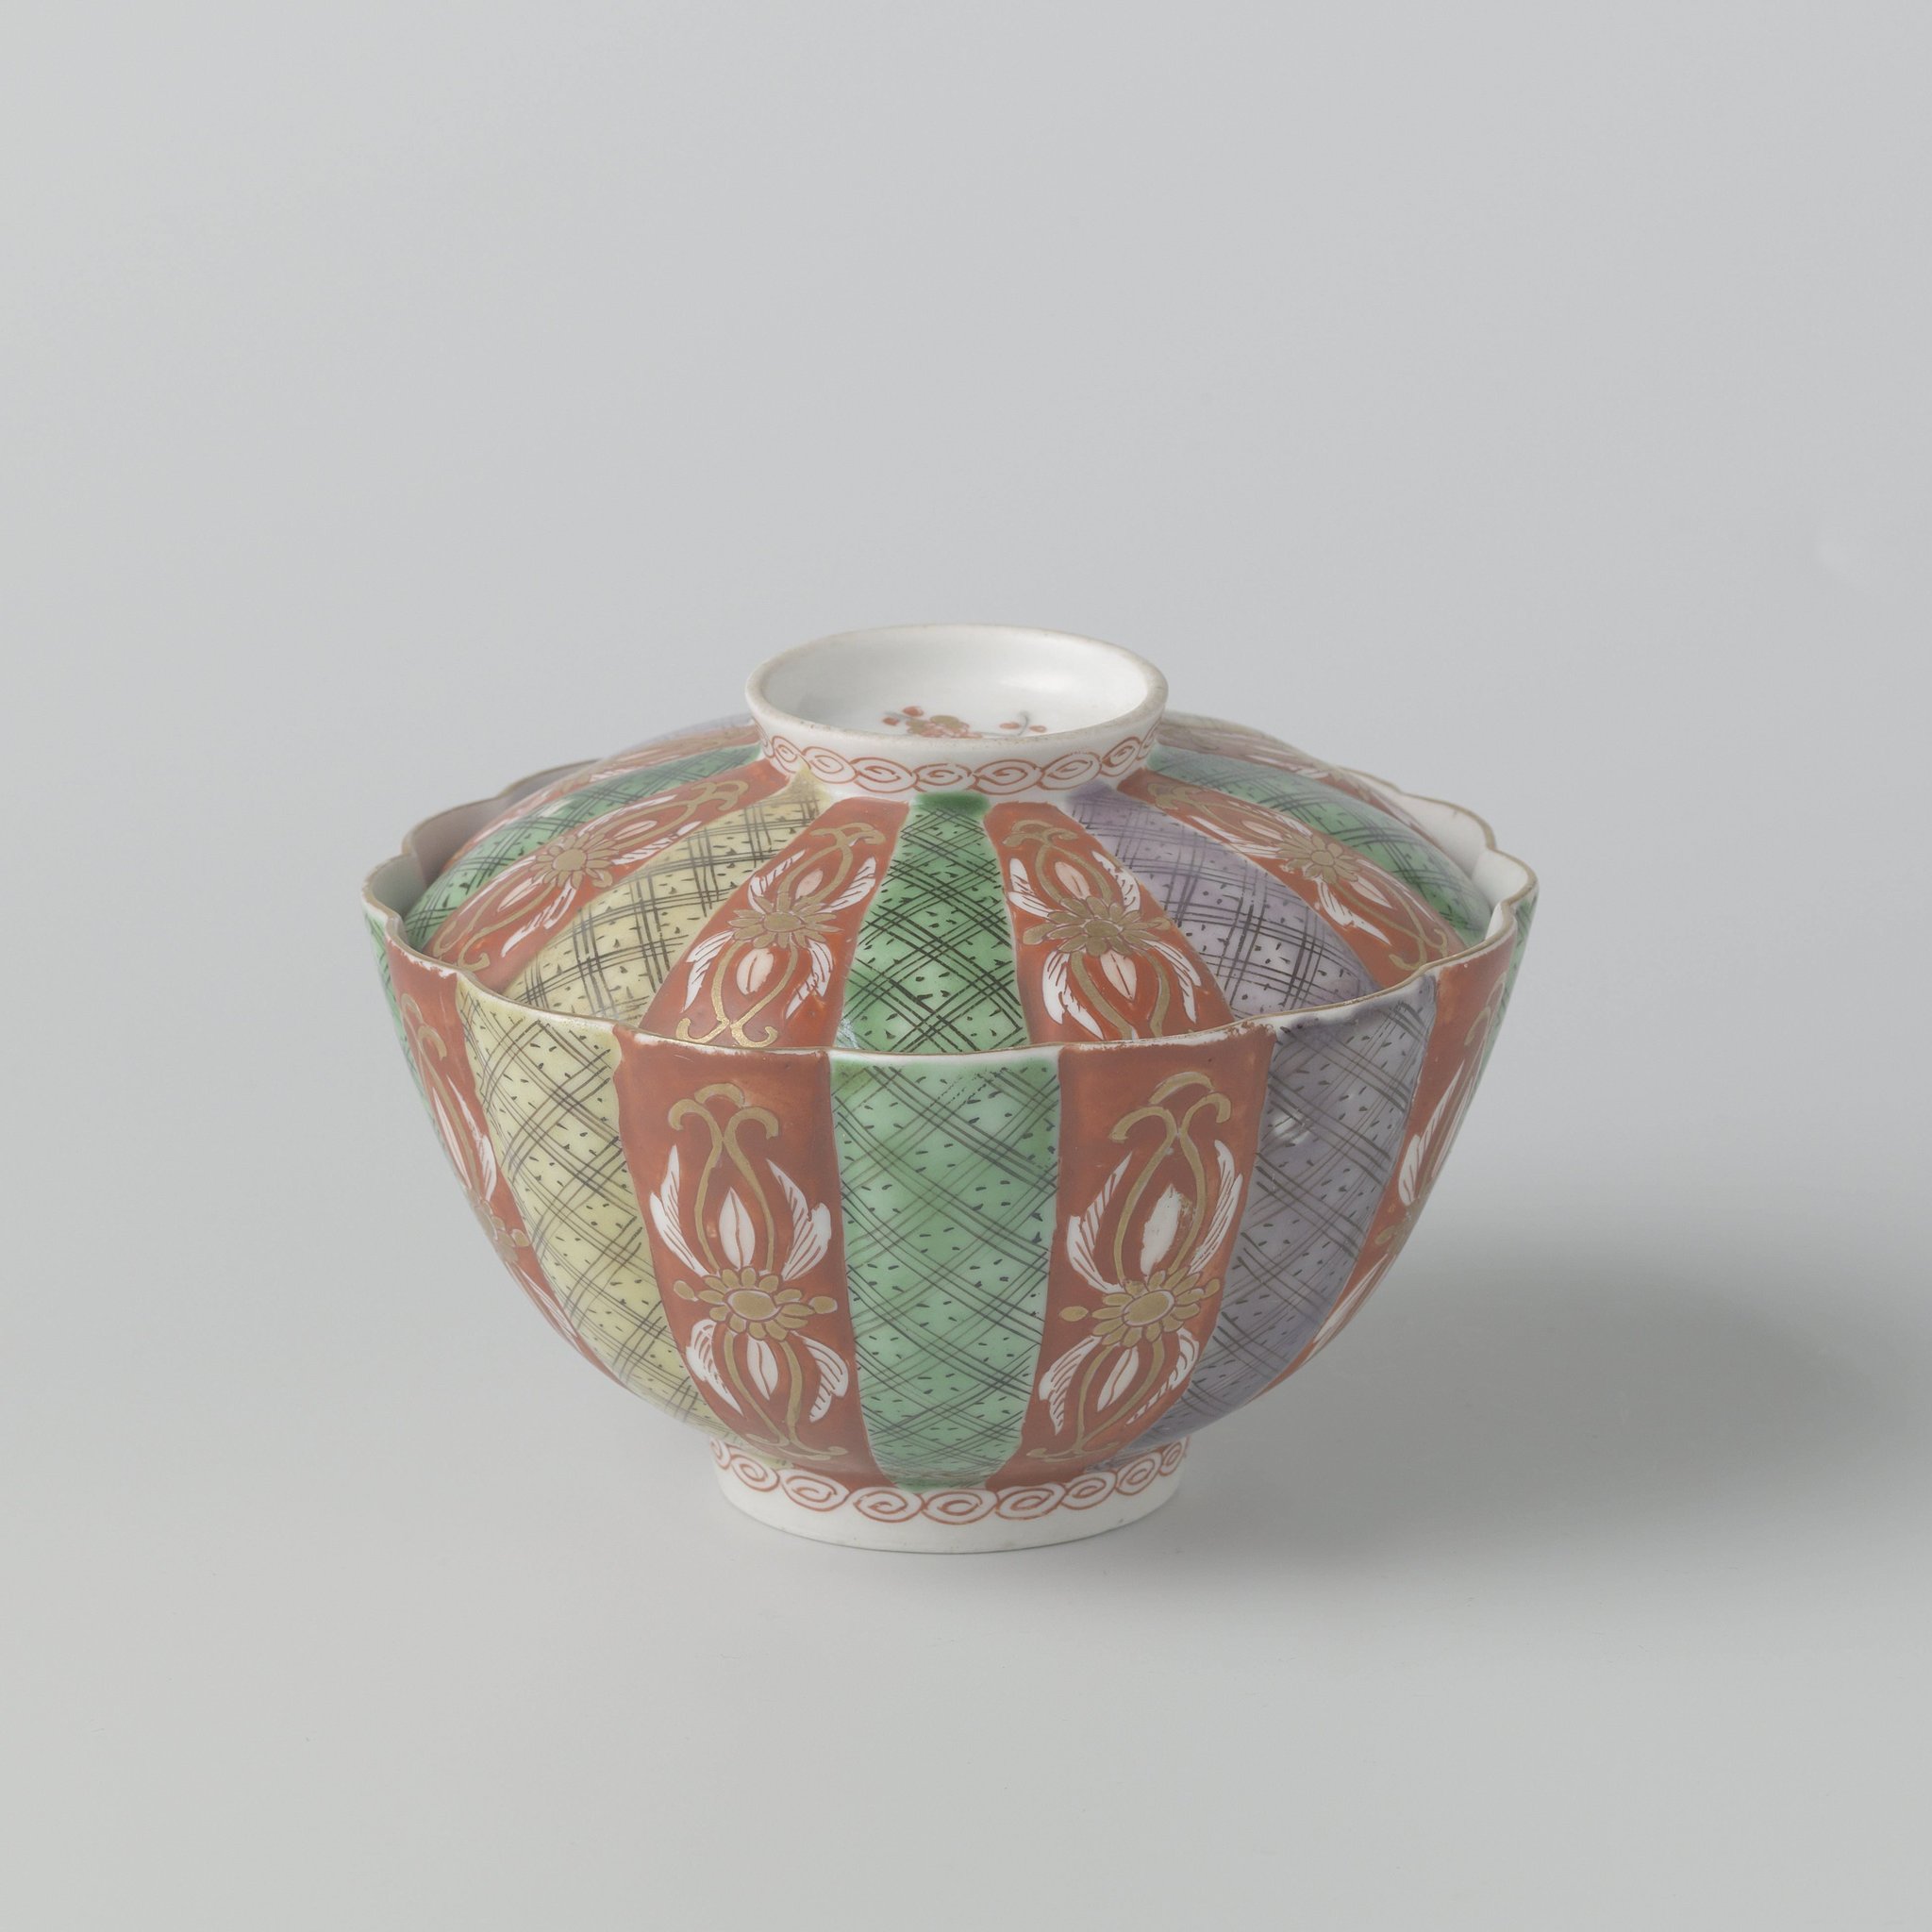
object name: covered bowl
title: Covered bowl with scrolls, diaper pattern and scattered flowers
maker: Anonymous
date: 1700-1749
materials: glaze, gold, porcelain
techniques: firing, gilding, turning, vitrification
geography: japan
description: AK-NM-6433 Twee kommen met deksels • Japans gekleurd porselein – Arita • Onderdeel van Royers porseleincollectie Dit zijn uitzonderlijke kommen – vergelijkbare stukken zijn in Europese collecties bij mijn weten niet gepubliceerd. Het was dus geen standaard exportproduct. Het enige vergelijkbare stuk vond ik in een Japanse collectie [Kurita 1965, nr. 16]. Des te interessanter dat het zich in de collectie van Royer bevindt. De sterke kleuren, de contrasterende banen met decoratieve patronen: het doet denken aan dessins voor stoffen. Het effect is bekend van kimono’s waarbij verschillende stoffen en plooien naast elkaar zichtbaar zijn (zie bijvoorbeeld RP-P-2008-151, en RP-P-2017-6161 voor een minder kleurrijk maar wel vroeg voorbeeld). Deze prenten zijn later dan deze kommen, niet omdat er in de tijd van de kommen geen kleurrijke kimono’s gedragen werden, maar omdat de prentkunst in het begin van de 18de eeuw nog niet tot volle bloei was gekomen. De voorliefde voor patronen en contrasten zal toen ook al bestaan hebben. Een schaal van Meissen-porselein uit 1730-35, Japans geïnspireerd, heeft deels een sterk vergelijkbare decoratie [Den Blaauwen 2000, nr. 154 (BK-1962-64)]. Het laat zien dat toen in ieder ge al dergelijke stukken in Dresden voorhanden waren. Stofpatronen als inspiratie voor porselein-decoratie wordt gezien als kenmerkend voor de Genroku-periode (1688-1704), doorlopend tot ca. 1720 [Fitski 2011, p. 101]. Dat houden we vooralsnog aan als datering van deze kommen. Als we dit inpassen in de ontwikkeling van het gekleurde porselein dan past het in de vroege 18de eeuw, als Imari zich ontwikkeld heeft (zie toelichting bij AK-NM-6458 voor het eerste begin). De gestileerde lotus in het rood is ook terug te vinden in de kom AK-NM-6399 (maar daar natuurlijk veel bescheidener). Dat zware rood zien we ook terug in het paar rolwagens AK-NM-6447 dat een goed voorbeeld is van volledig ontwikkeld en exuberant Imari, toegesneden op de Europese smaak. Maar dat laatste geldt niet zozeer voor deze kommen. Dit is eerder exuberantie voor Japanse liefhebbers, niet per se van de meest verfijnde soort. Op de band met stoffen is al gewezen, twee surimono (ook weer later dan de kommen, maar toch) laten porselein zien dat in wezen hetzelfde decoratie principe volgt: vol, gekleurd en contrasterende patronen. En die surimono waren zonder twijfel voor Japanse liefhebbers gemaakt (RP-P-1958-322 en RP-P-1958-422). De binnenzijde wijkt sterk af van de buitenkant: wit met een aantal gestileerde chrysanten. Bronnen : H. Kurita, Kurita collection, Tokio, 1965. Abraham L. den Blaauwen, Meissen Porcelain in the Rijksmuseum, Zwolle/Amsterdam, 2000. Menno Fitski, Kakiemon porcelain: a handbook, Leiden/ Amsterdam, 2011.